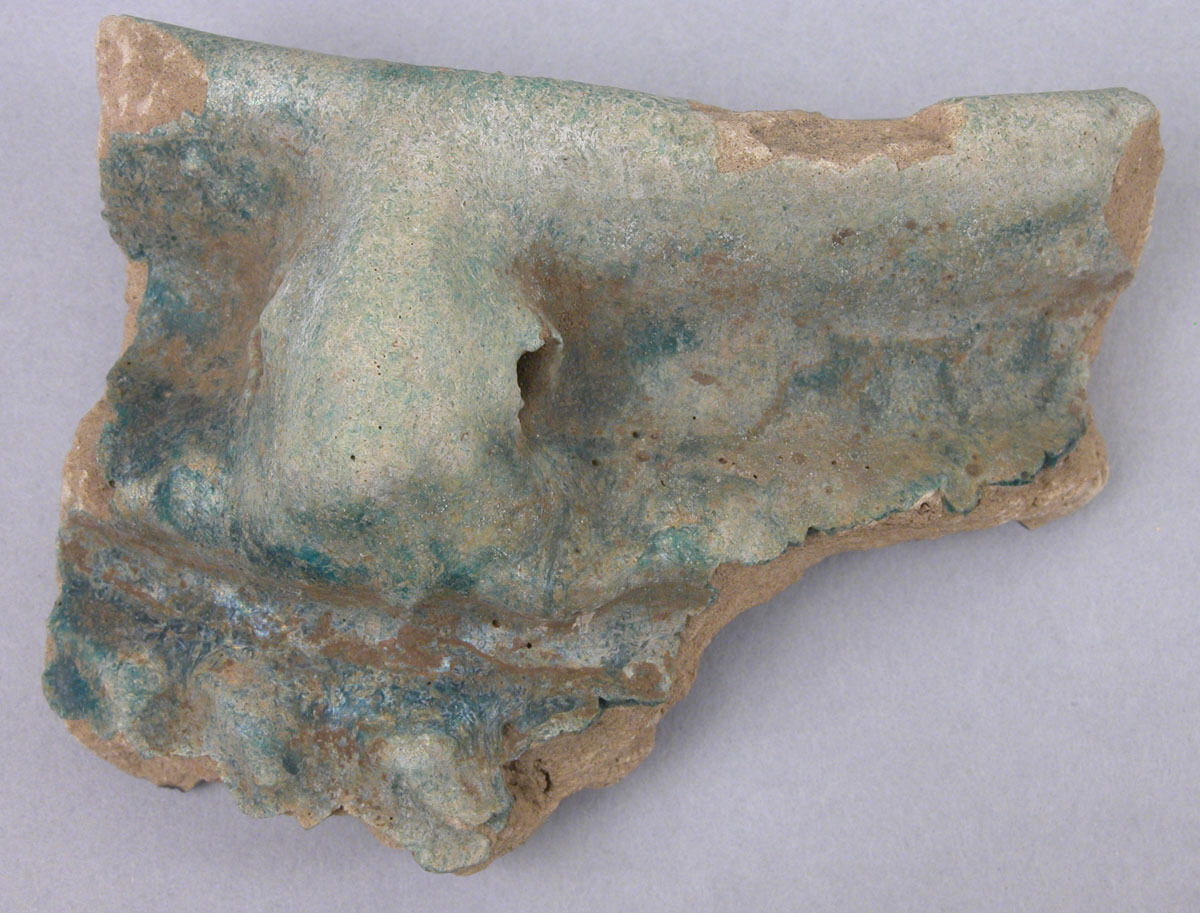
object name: fragment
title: Ceramic Fragment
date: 201-800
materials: earthenware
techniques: glazing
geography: iraq